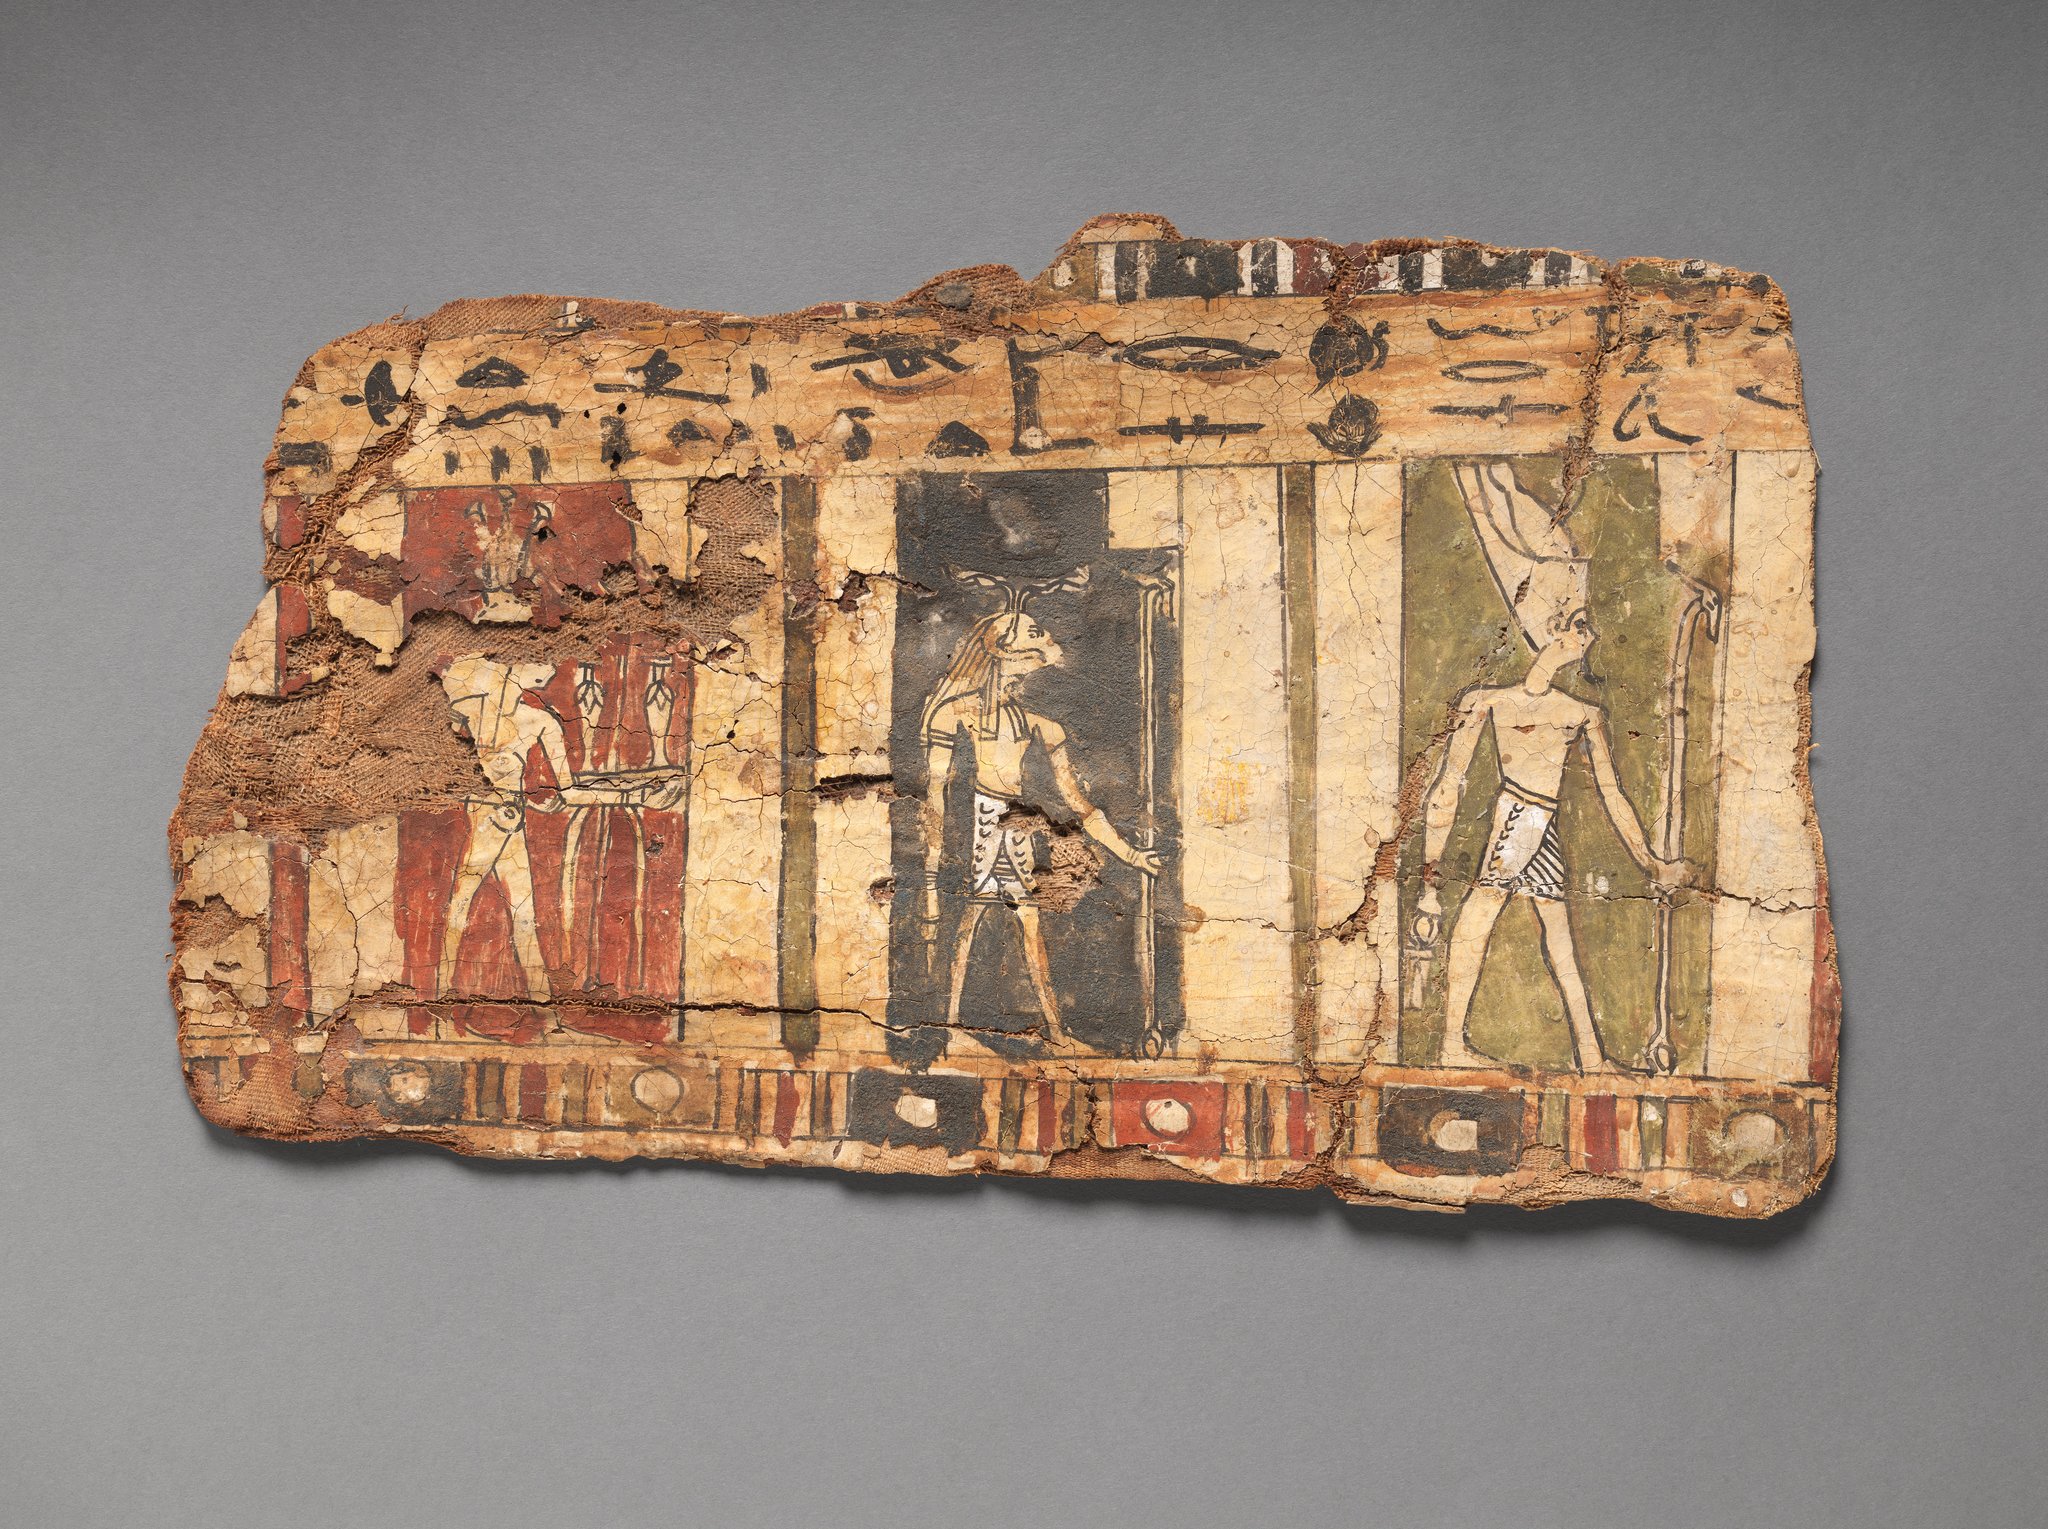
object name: cartonnage fragment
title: Fragment of cartonnage depicting three deities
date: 200 BCE-200 CE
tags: deities